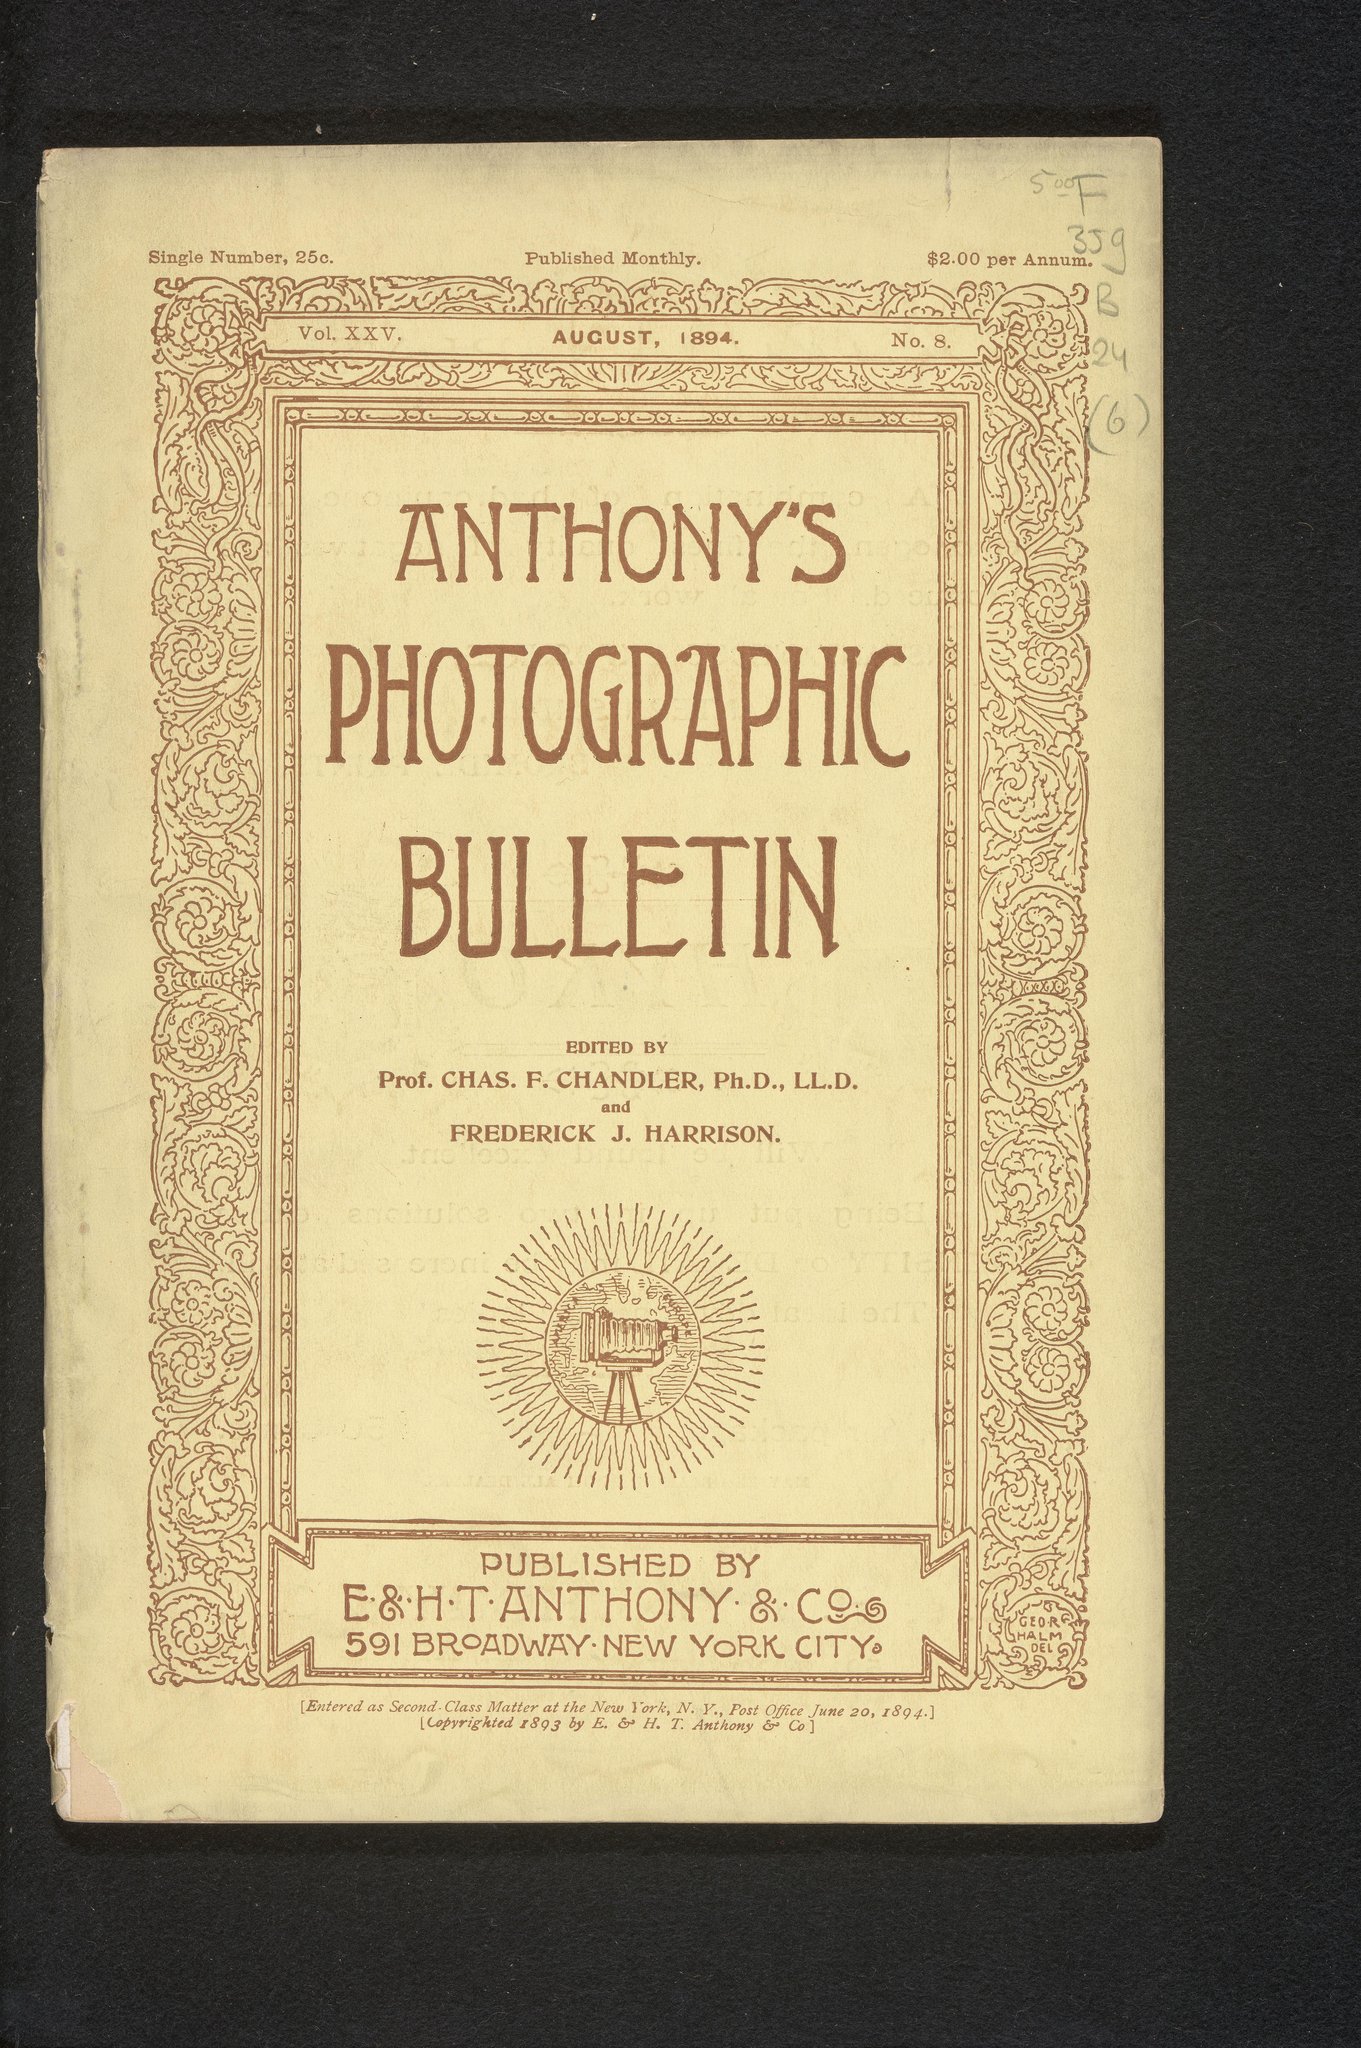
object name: book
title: Anthony's photographic bulletin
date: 1893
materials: paper, photographic support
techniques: printing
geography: new york city